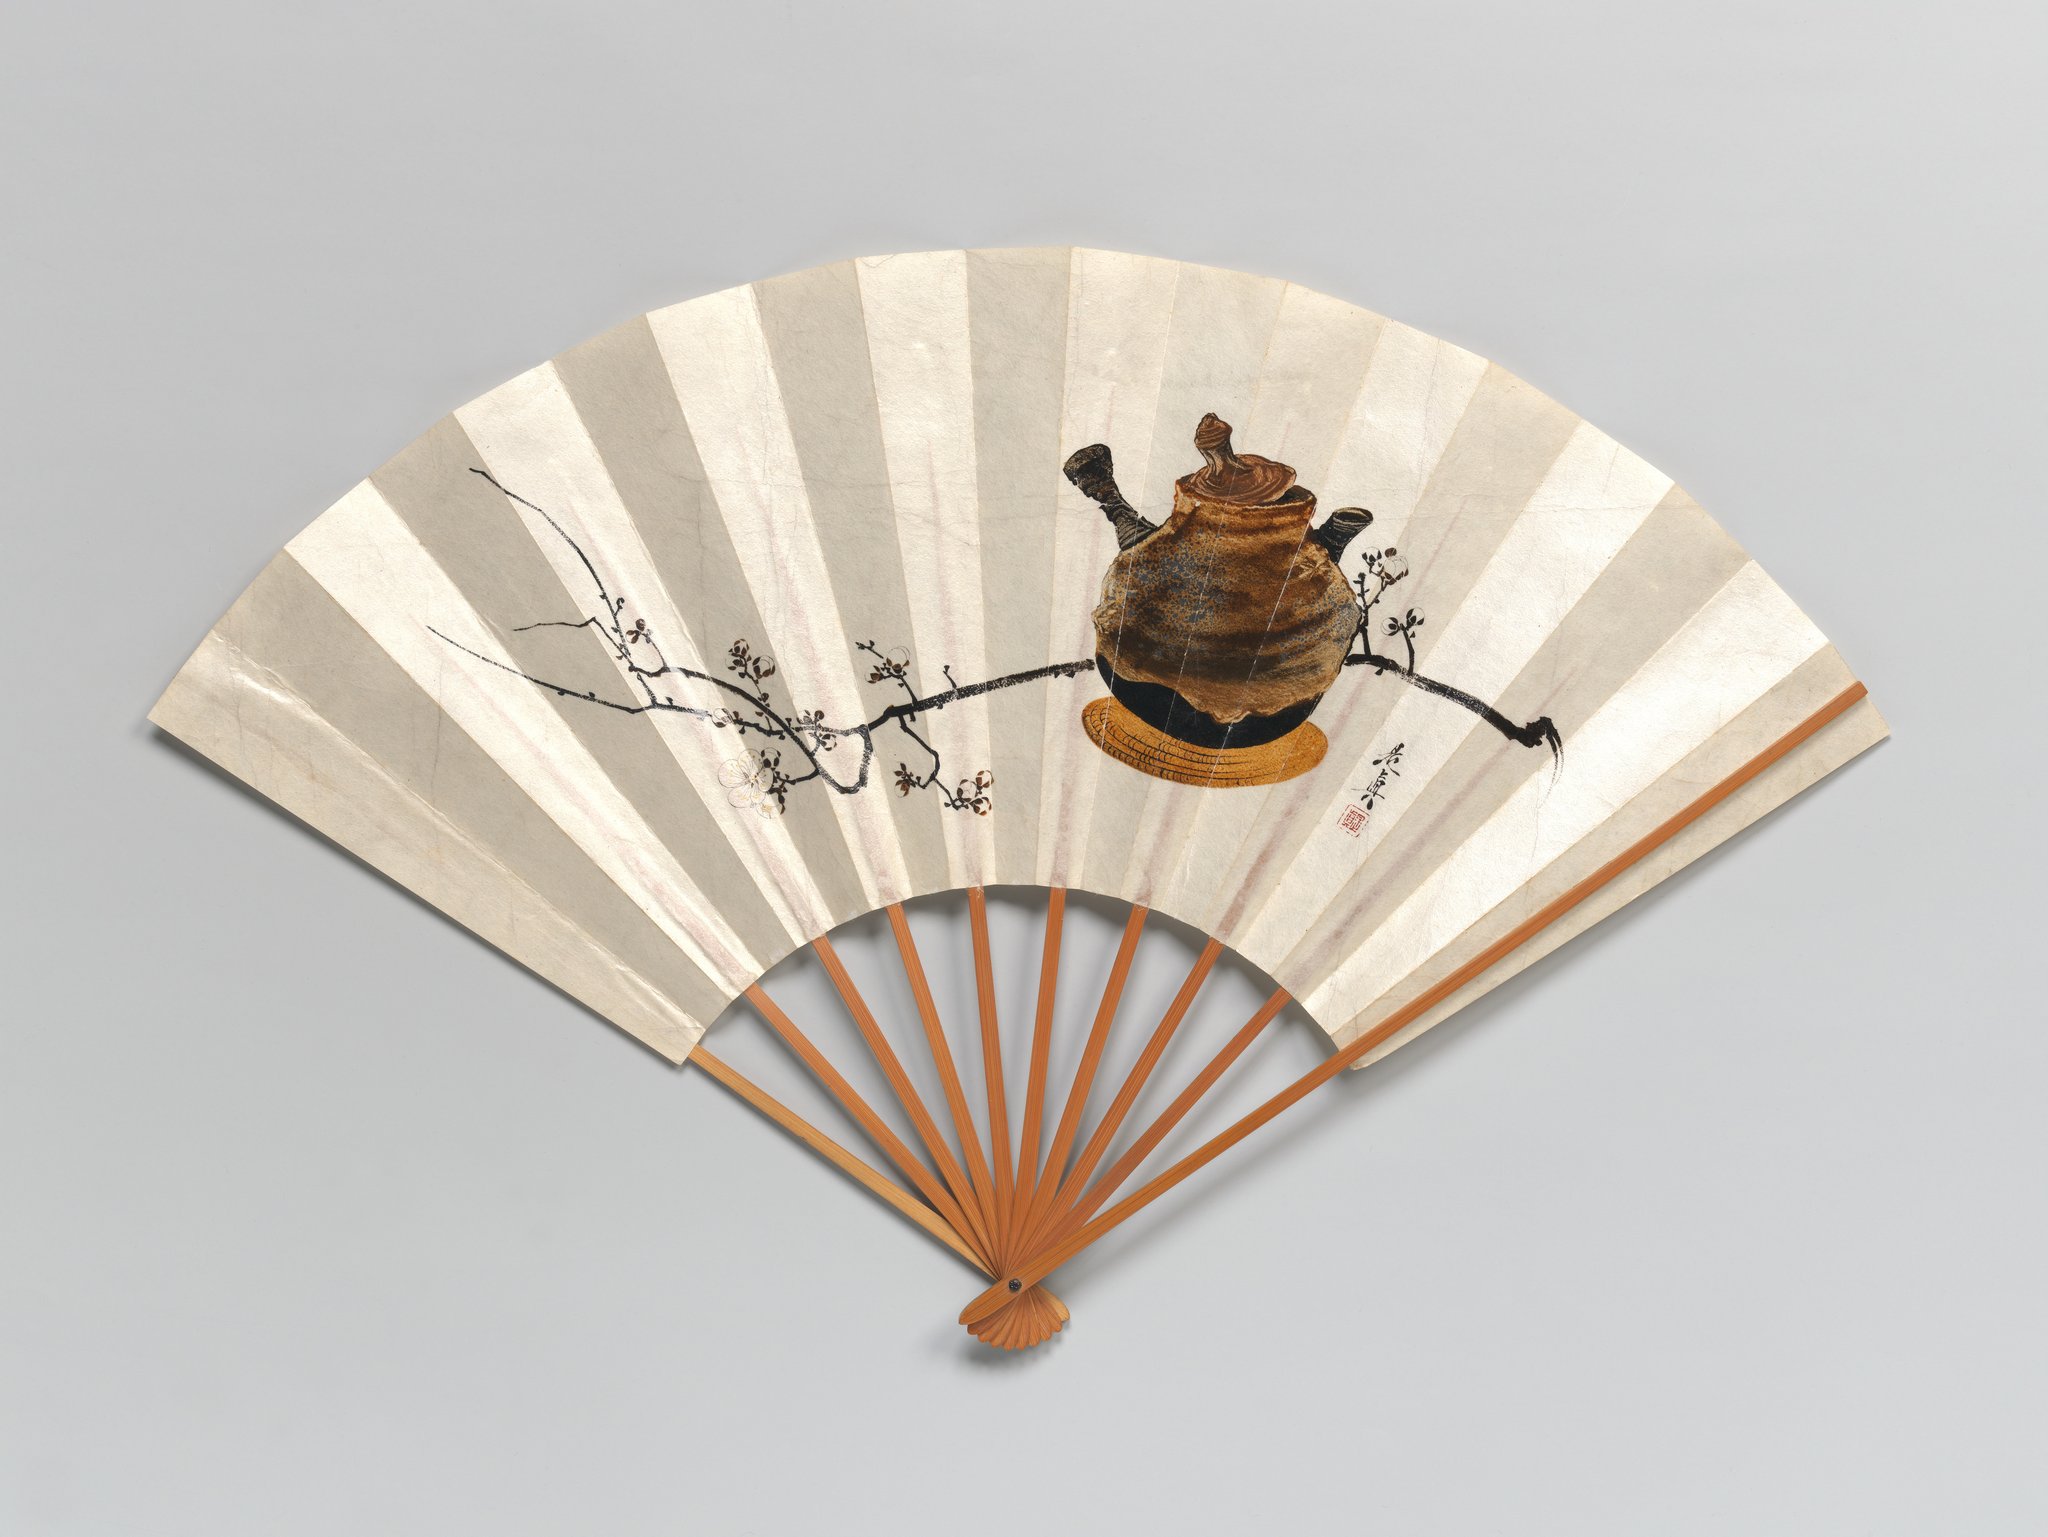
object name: folding fan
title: Plum Branch and Teapot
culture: japanese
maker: shibata zeshin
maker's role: artist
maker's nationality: japanese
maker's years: 1807-1891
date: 1868-1912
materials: lacquer, paper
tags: teapots